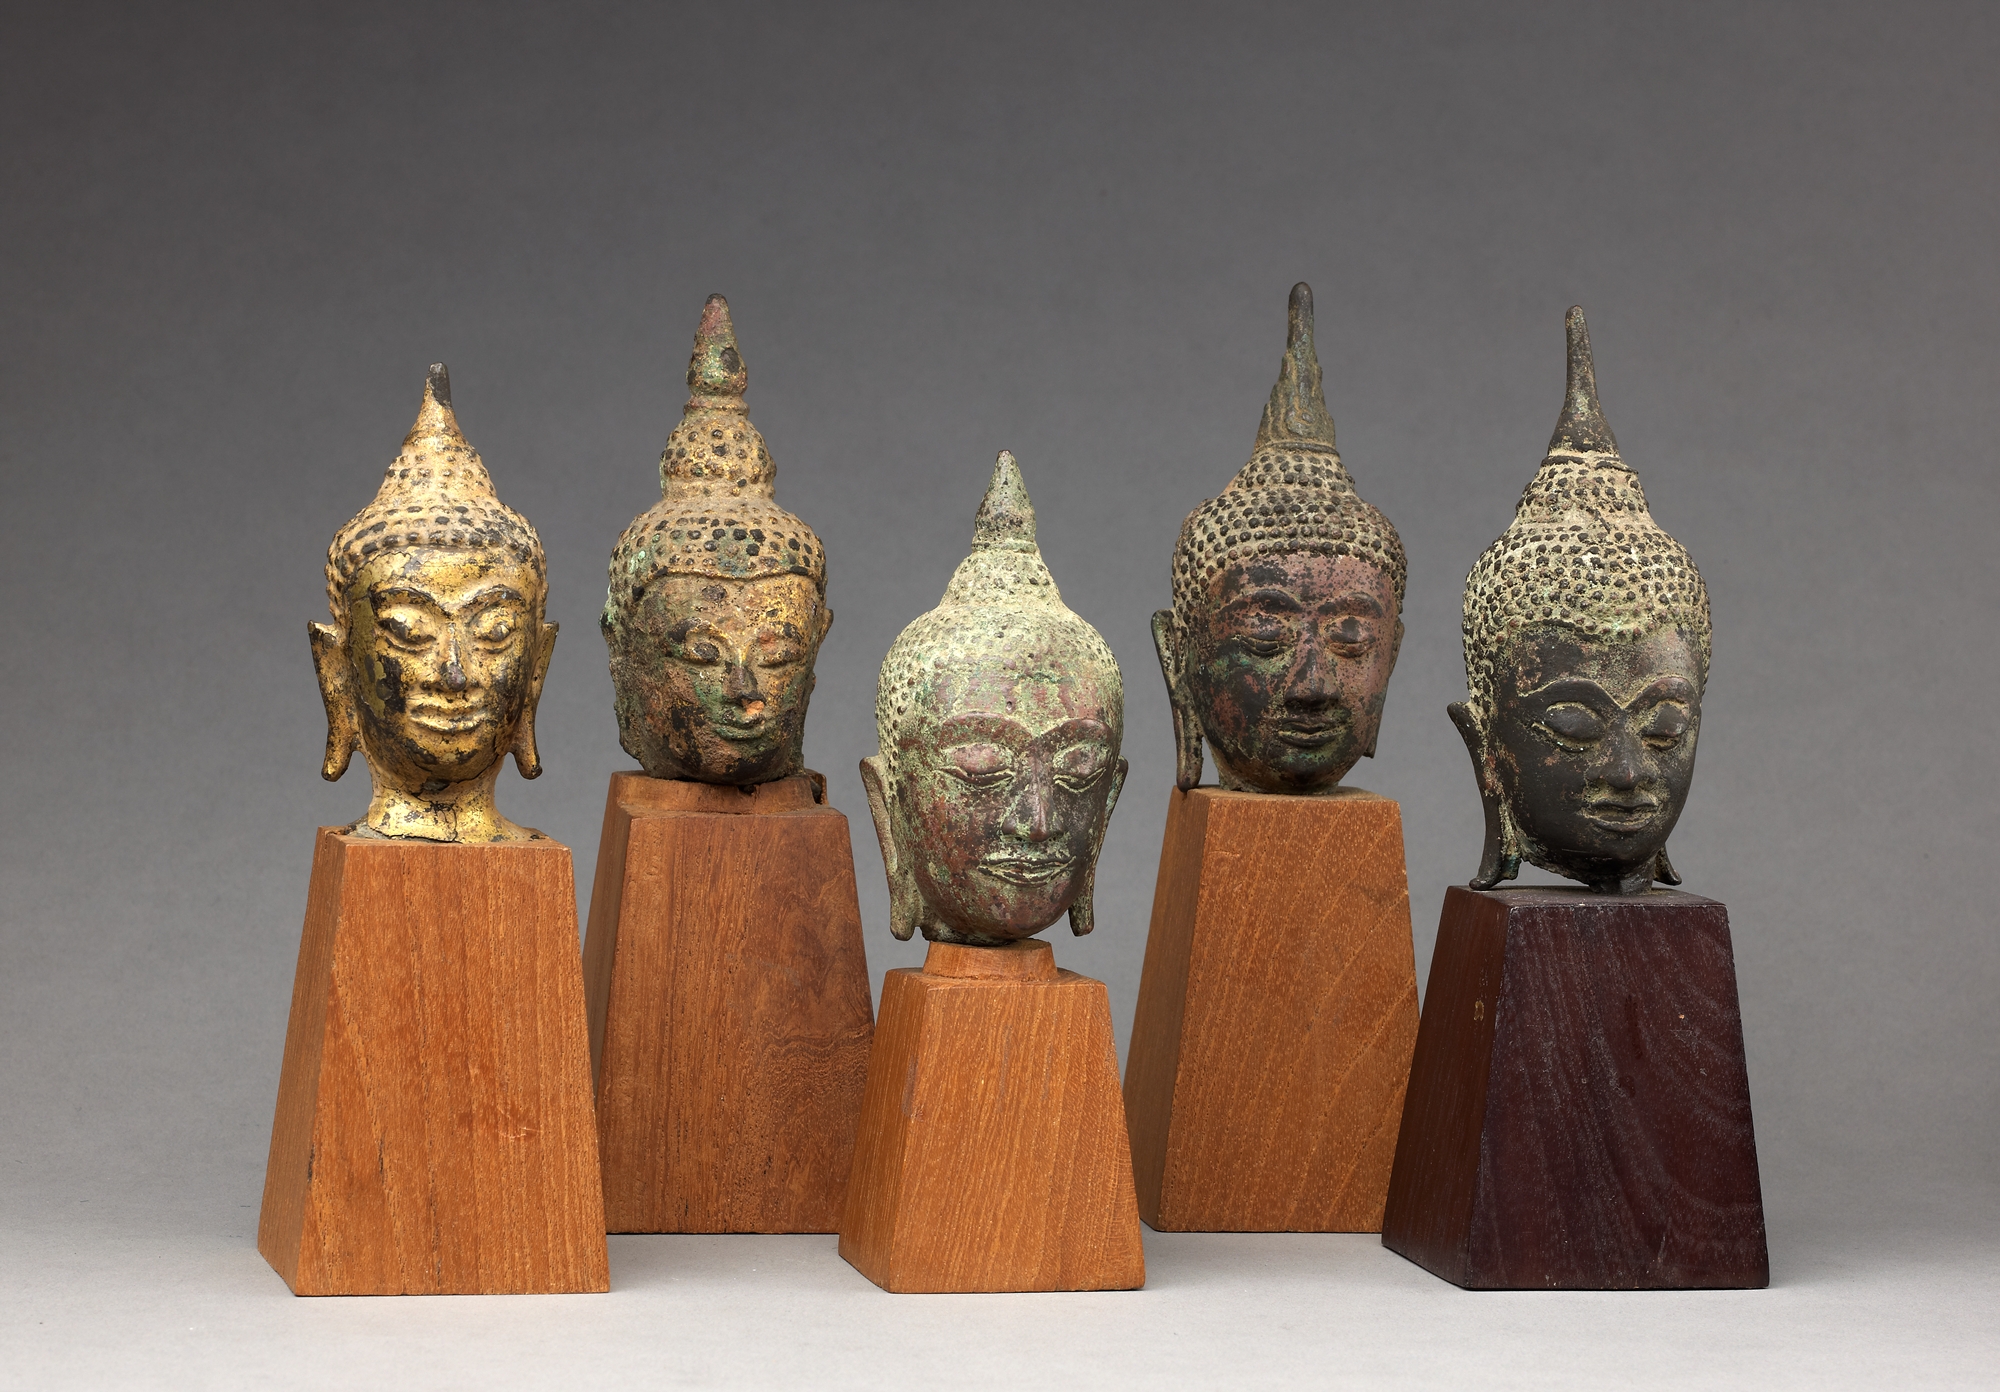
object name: sculpture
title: Head of the Buddha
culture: thai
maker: thai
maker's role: artist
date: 1767-1900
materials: copper alloy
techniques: gilding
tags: heads,buddha